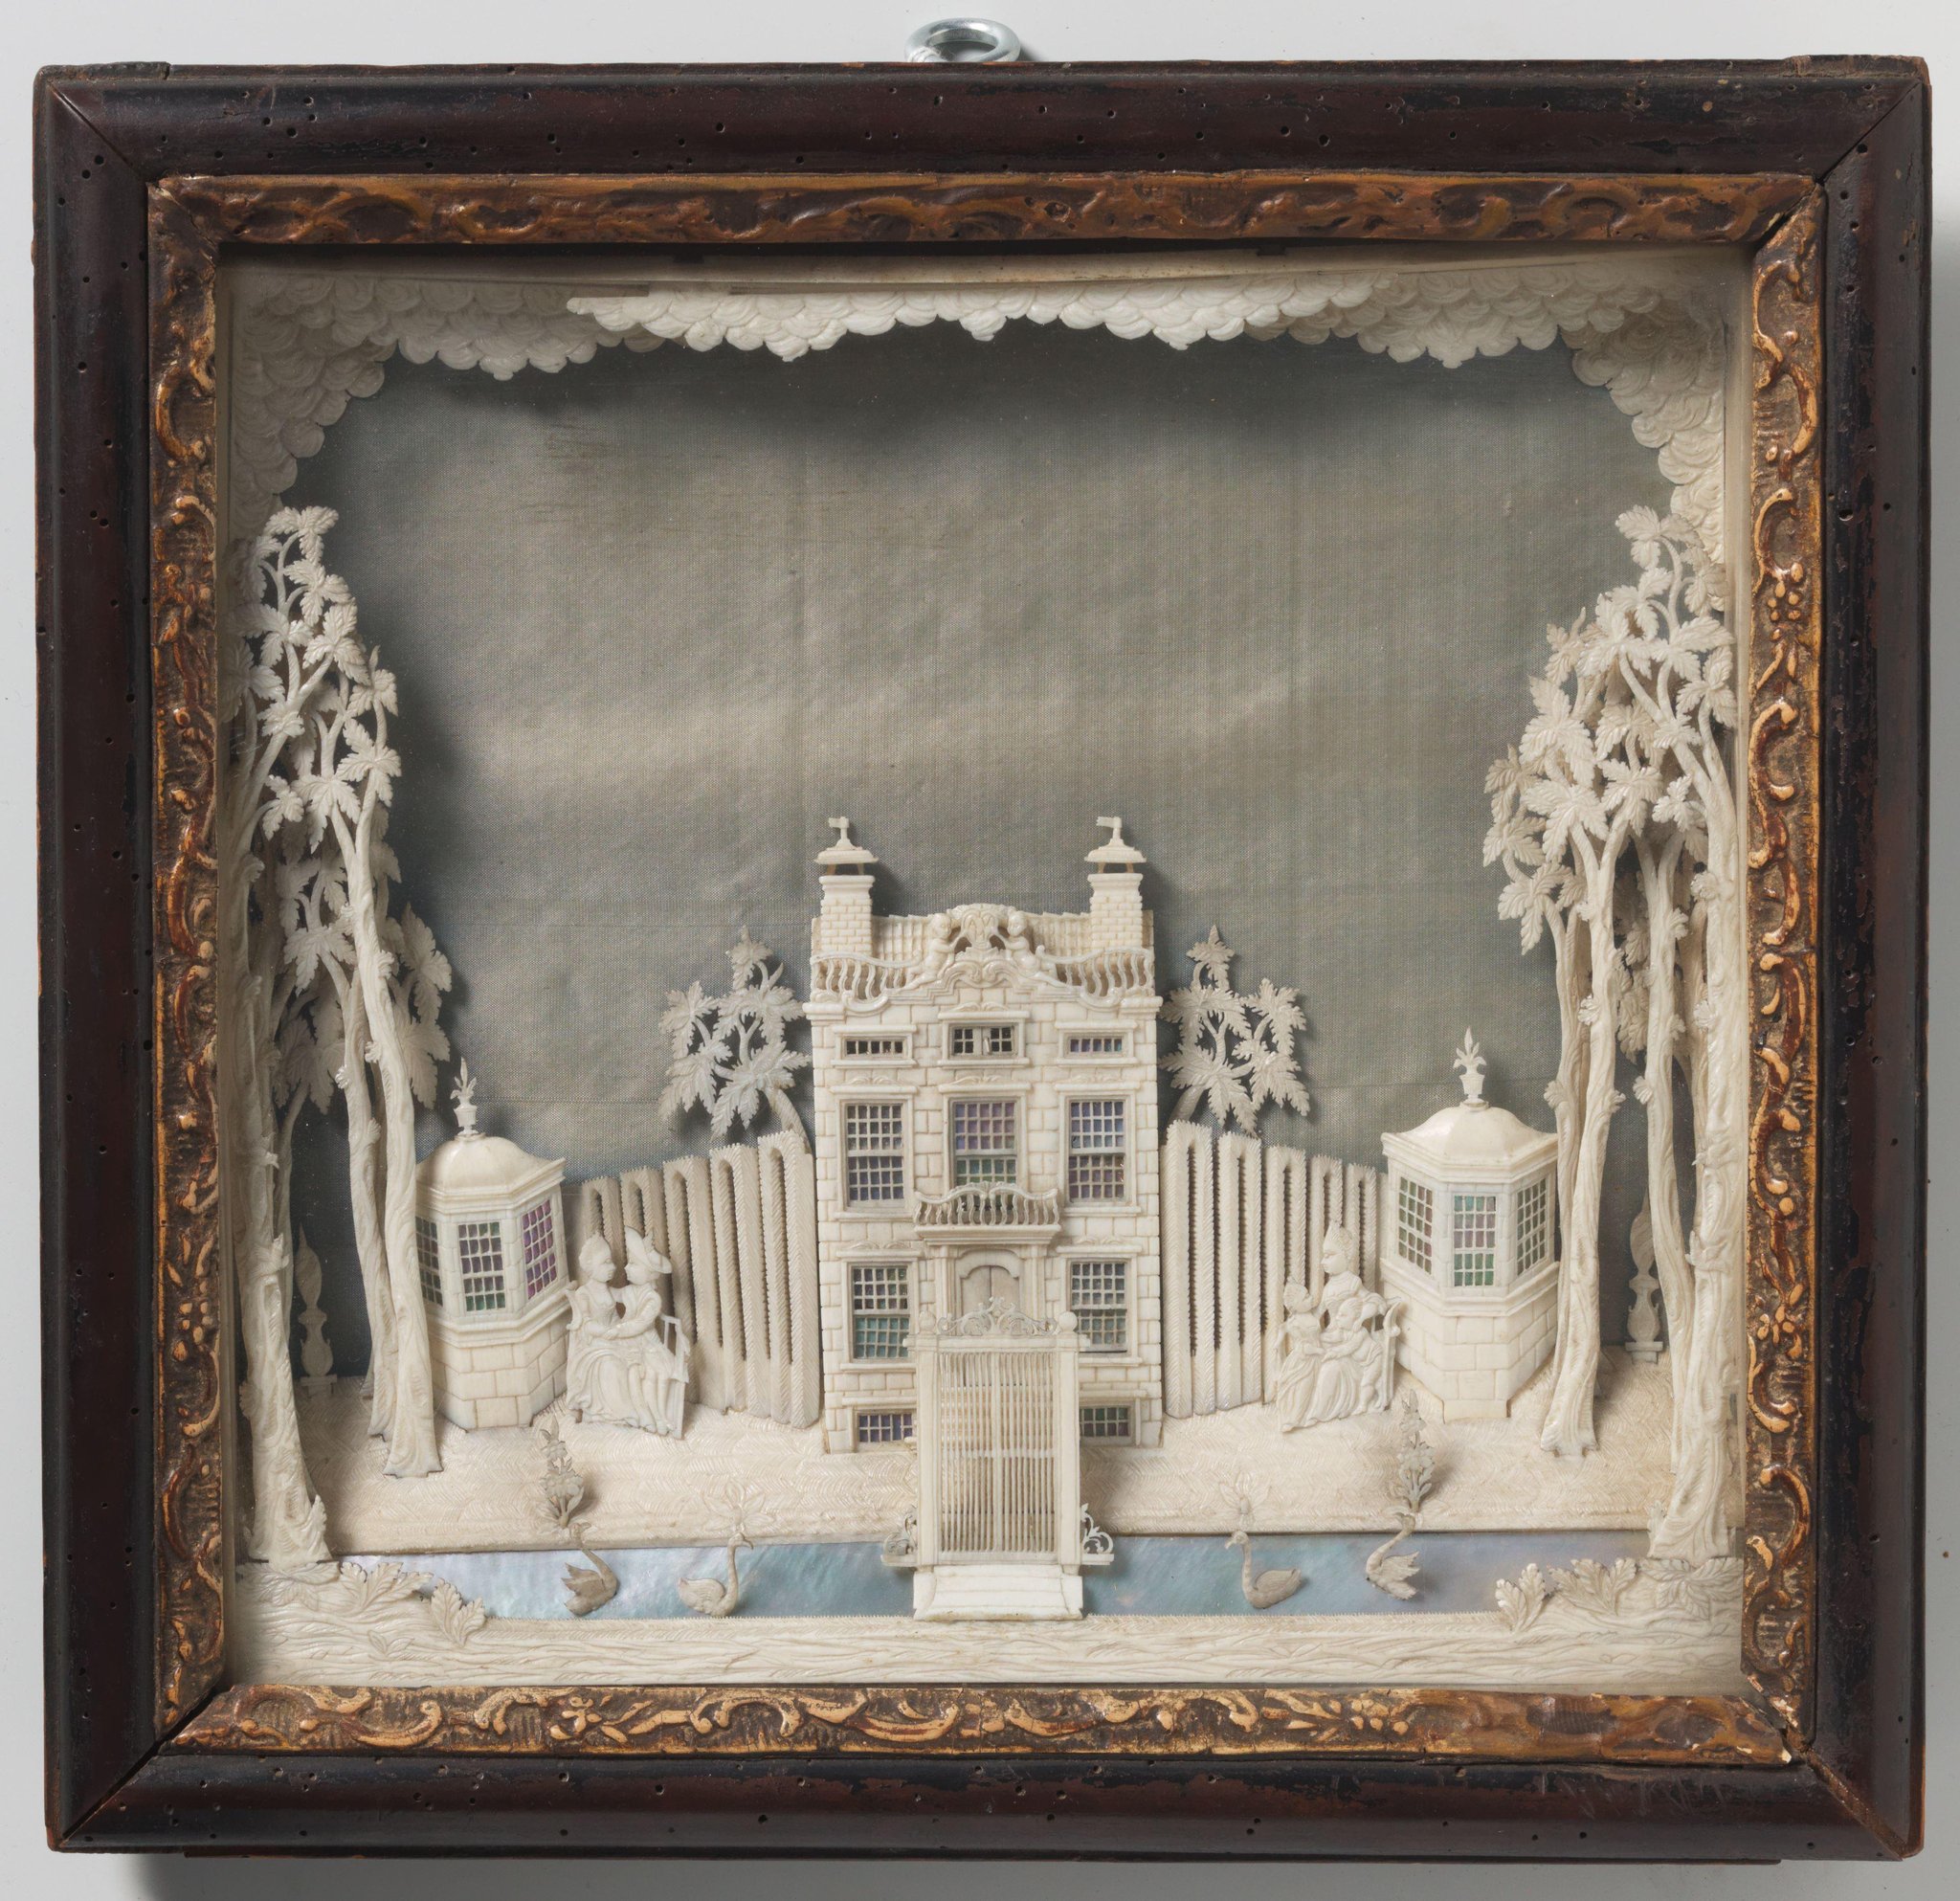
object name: decoratief object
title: Bavelaar van ivoor en parelmoer in donkerbruine lijst met verguld inlegstuk. Huis aan gracht waarin zwanen, met drie verdiepingen, bekroond door een balustrade met schilddragende putti. In het schild de letter AVM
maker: Anonymous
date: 1700-1750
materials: glass, ivory, mother of pearl, silk, wood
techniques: gilding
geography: northern netherlands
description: Bavelaar van ivoor en parelmoer, gevat in een donkerbruine lijst met verguld inlegstuk. De bavelaar vertoont een huis van drie verdiepingen, bekroond door een balustrade met schilddragende putti, gelegen aan een smalle gracht met brug. In het schild zijn de letters AVM aangebracht. In het water zwemmen vier zwanen. Links en rechts een door hagen afgesloten tuin met tuinkoepels en op een tuinbank zittende figuren. De glasruiten en het water zijn van parelmoer, de achtergrond is van blauwe zijde.